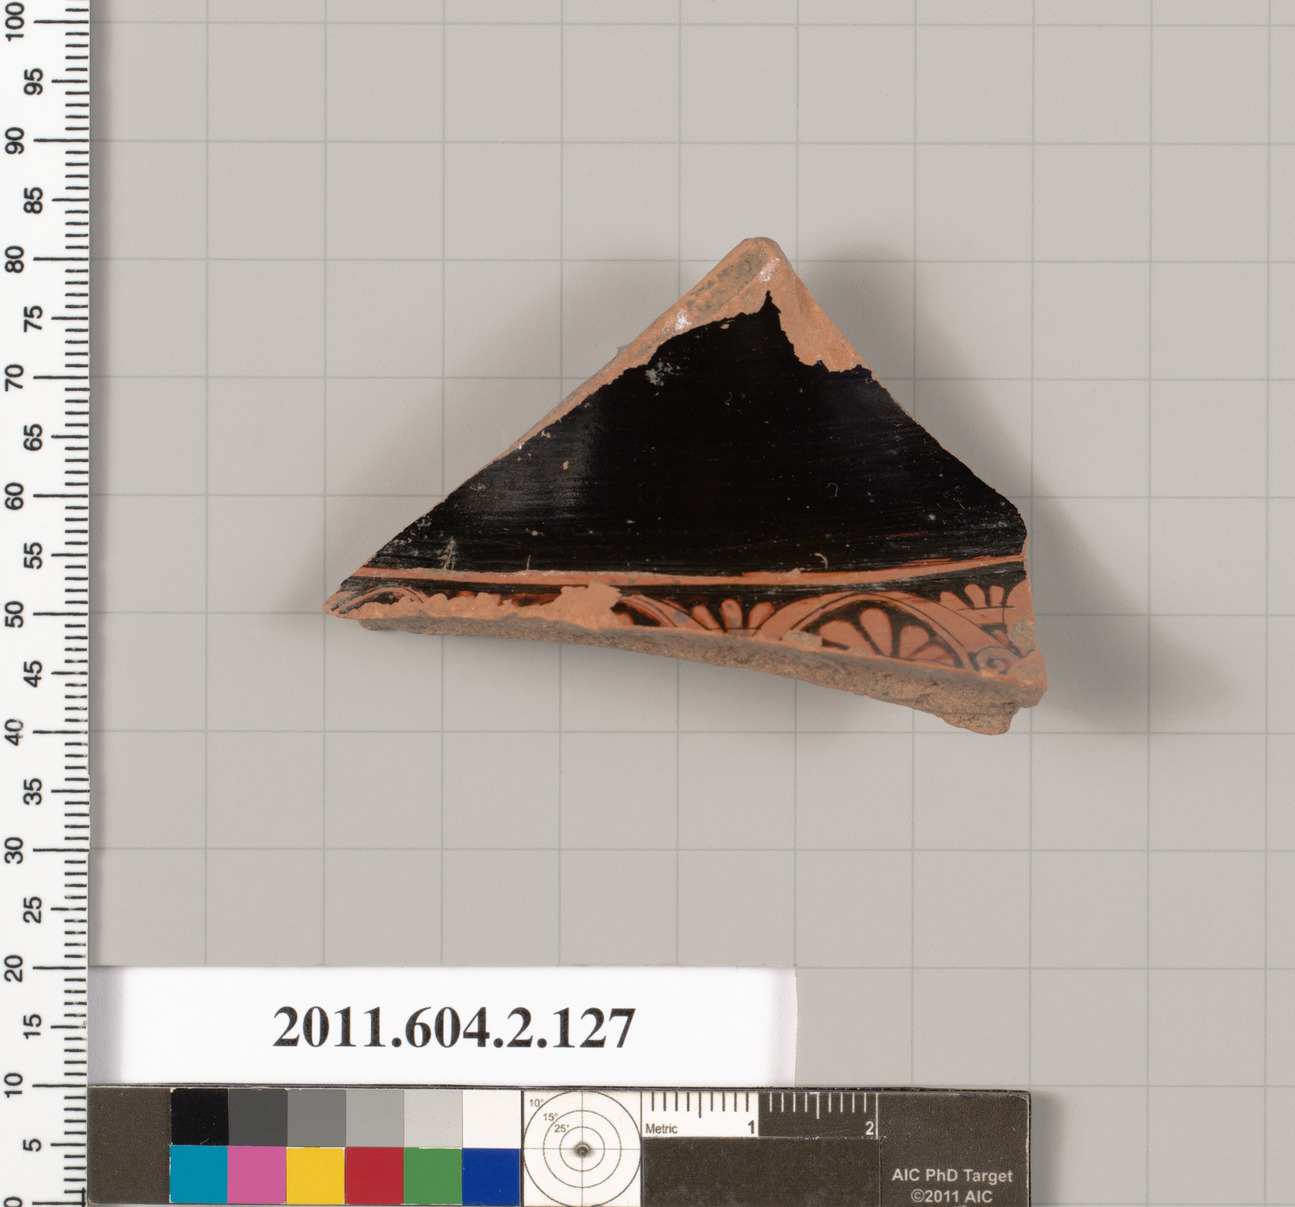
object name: pelike fragment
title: Terracotta fragment of a pelike (jar)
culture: greek, attic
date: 500-476 BCE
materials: terracotta